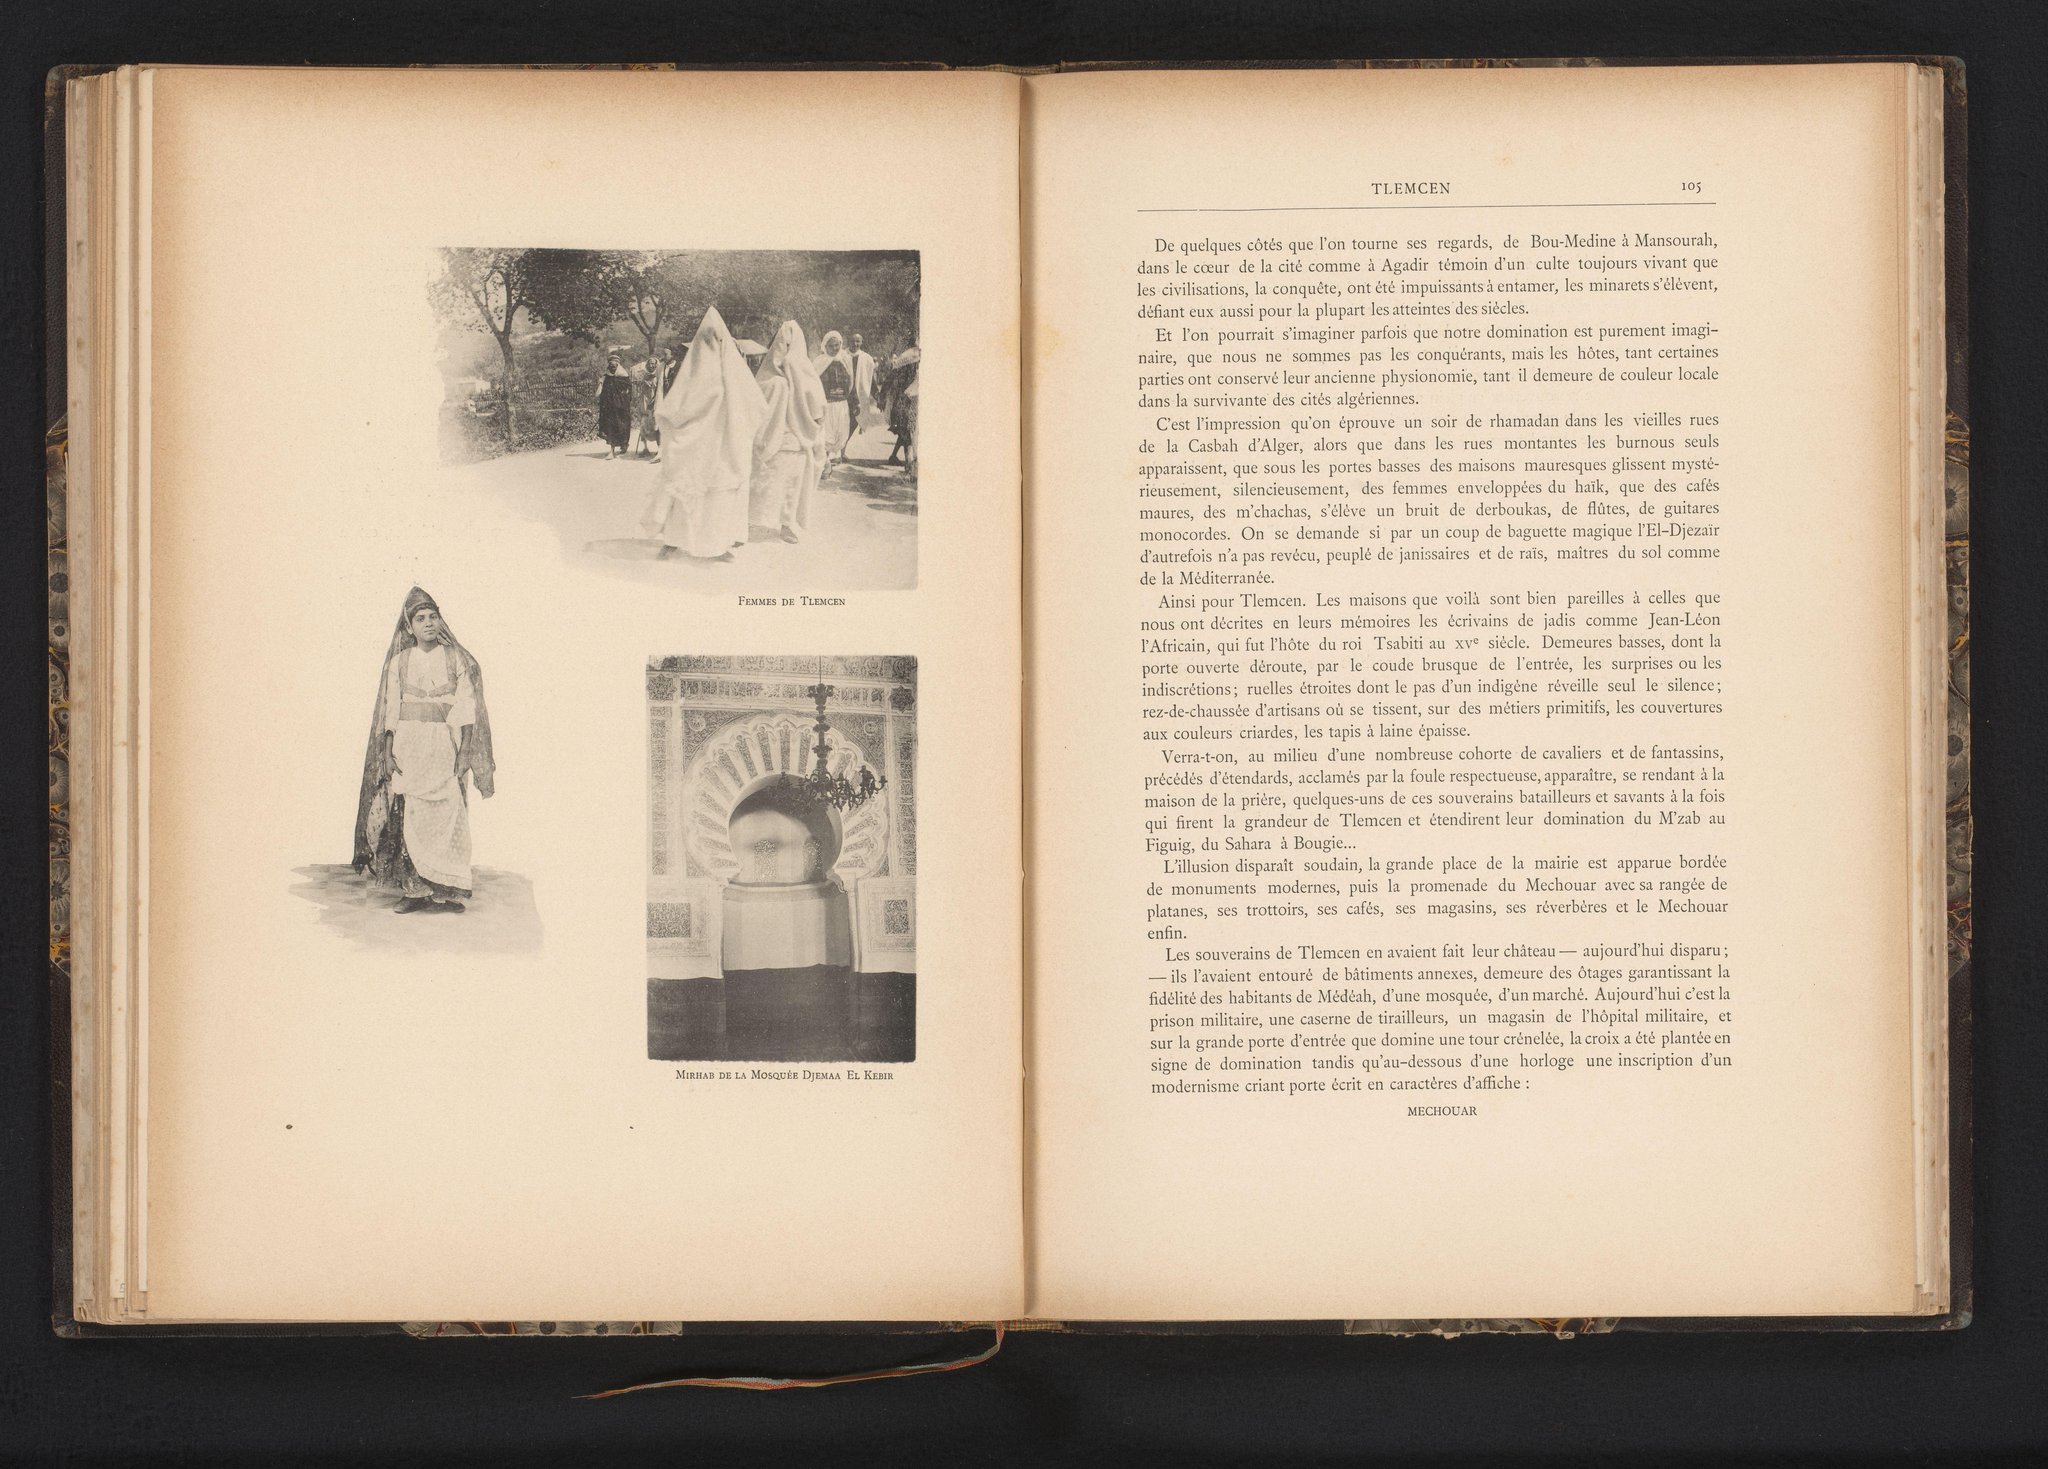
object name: page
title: Mirhab de la Mosquée Djemaa El Kebir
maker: jules gervais-courtellemont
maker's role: fotograaf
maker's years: 1863-1931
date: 1888-1893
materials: paper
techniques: photograph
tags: temple, shrine ~ islam, mohammedanism